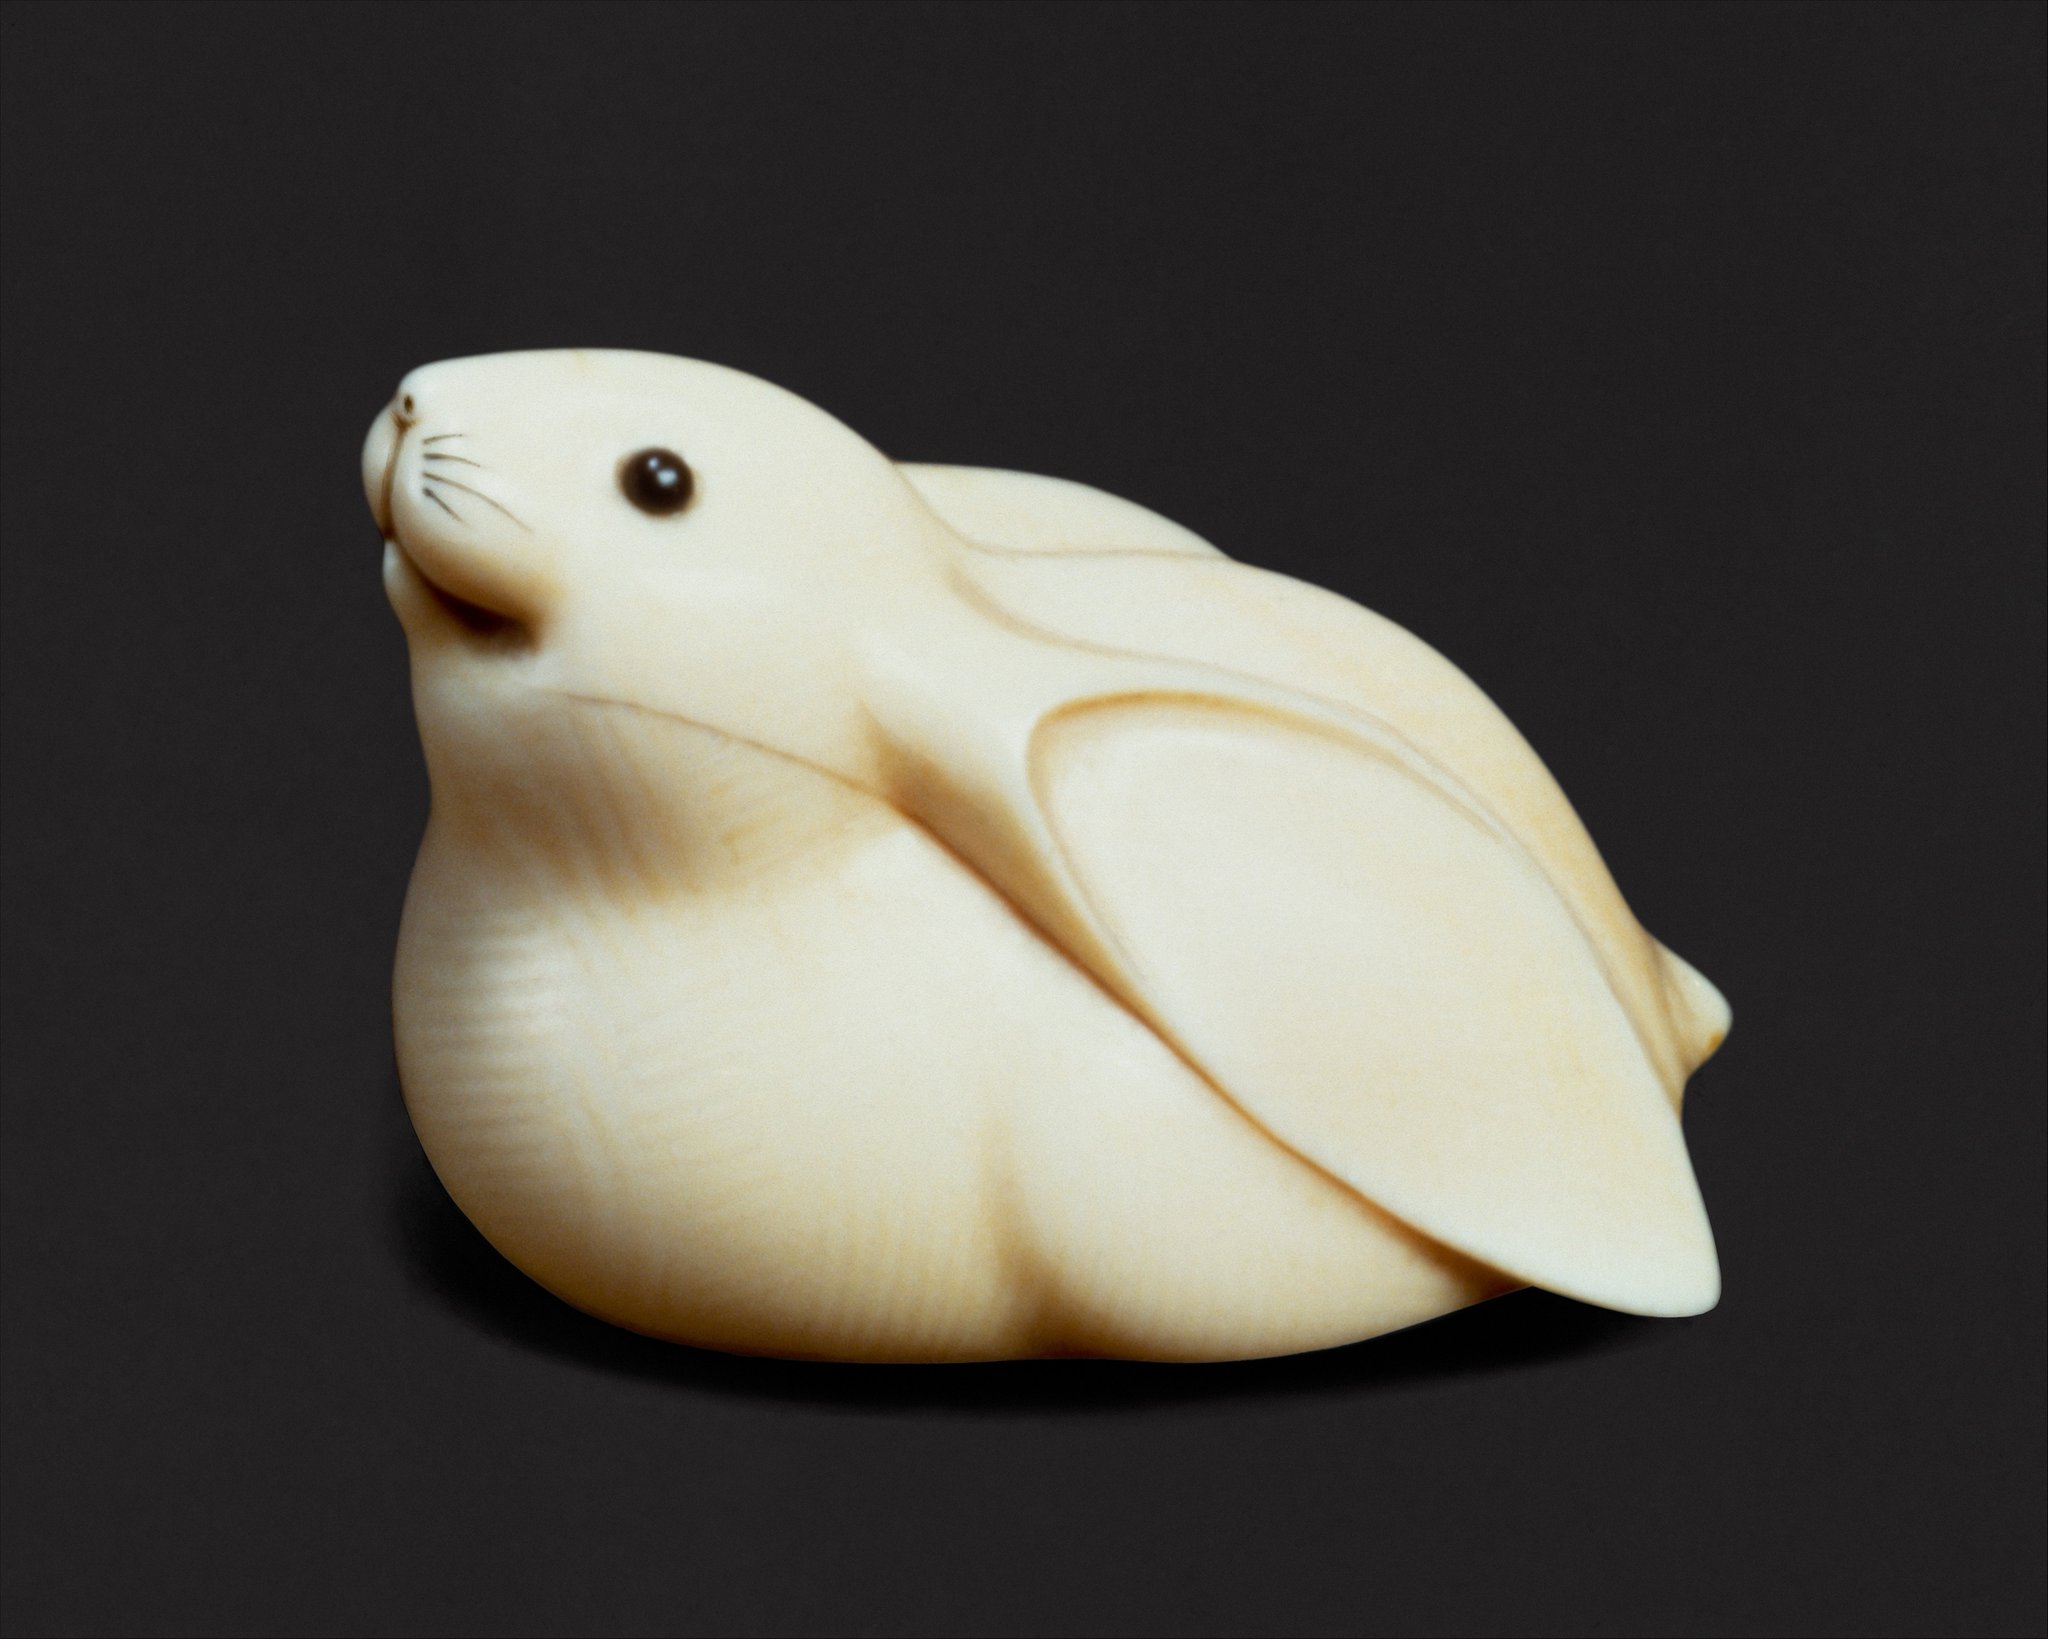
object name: netsuke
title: Rabbit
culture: japanese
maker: ōhara mitsuhiro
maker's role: artist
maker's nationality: japanese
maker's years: 1810-1875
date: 1834-1866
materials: ivory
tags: rabbits